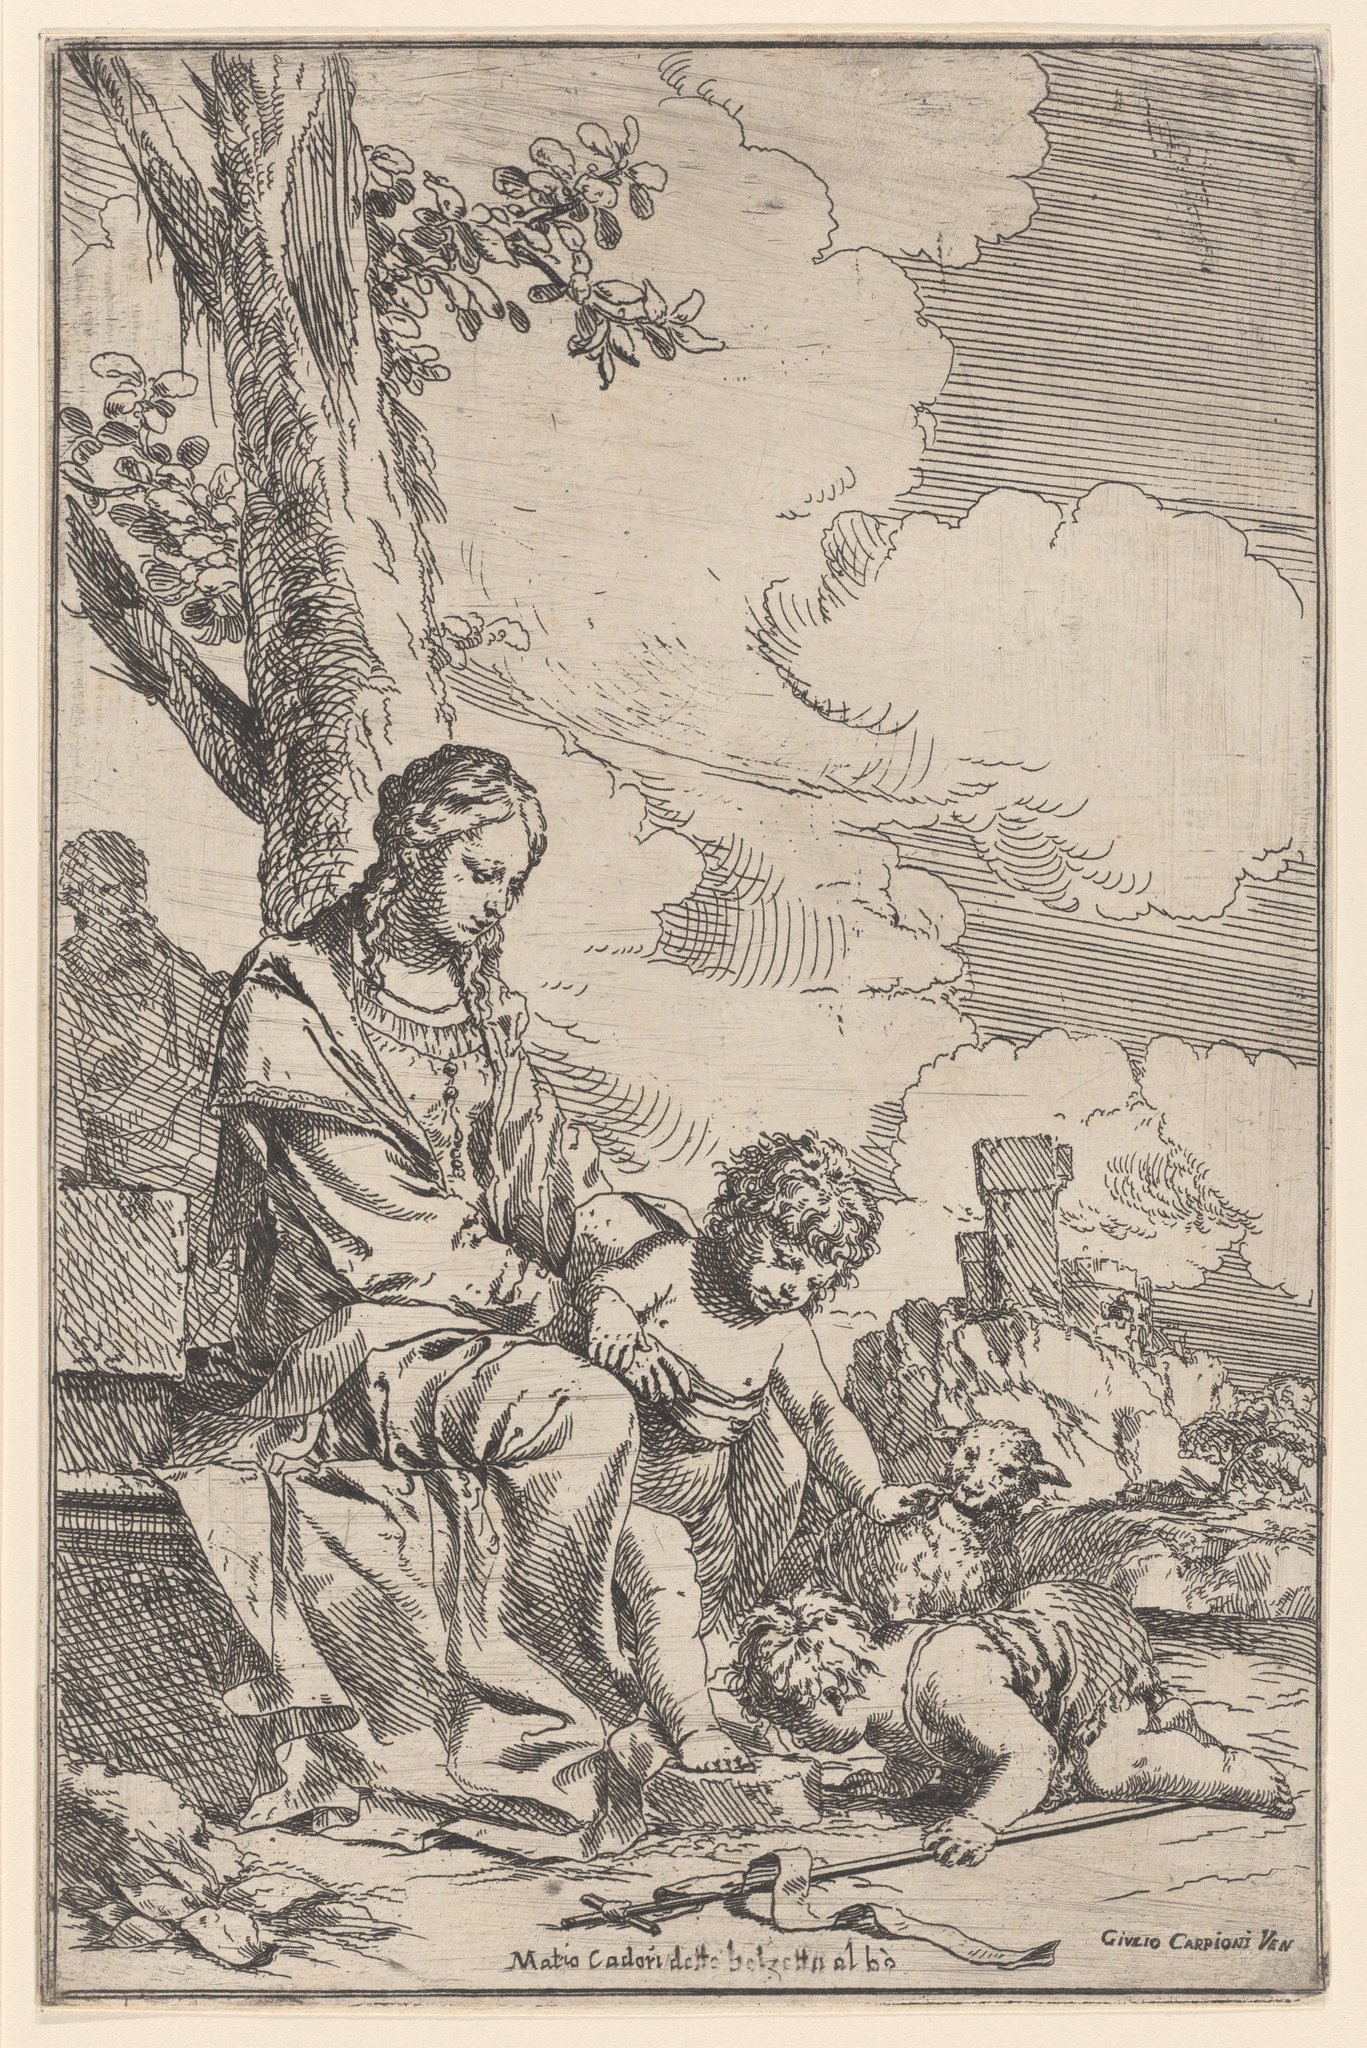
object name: print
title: The Holy Family with the infant Saint John kissing Christ's feet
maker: giulio carpioni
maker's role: artist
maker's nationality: italian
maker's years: 1613-1678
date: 1640-1660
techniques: etching